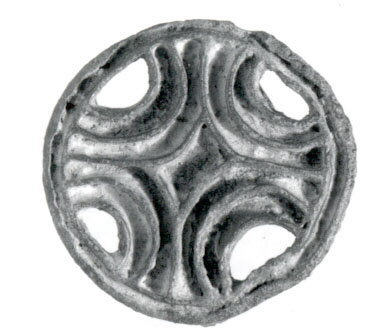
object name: stamp seal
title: Compartmented stamp seal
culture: bactria-margiana archaeological complex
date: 2333-1668 BCE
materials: copper alloy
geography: bactria-margiana